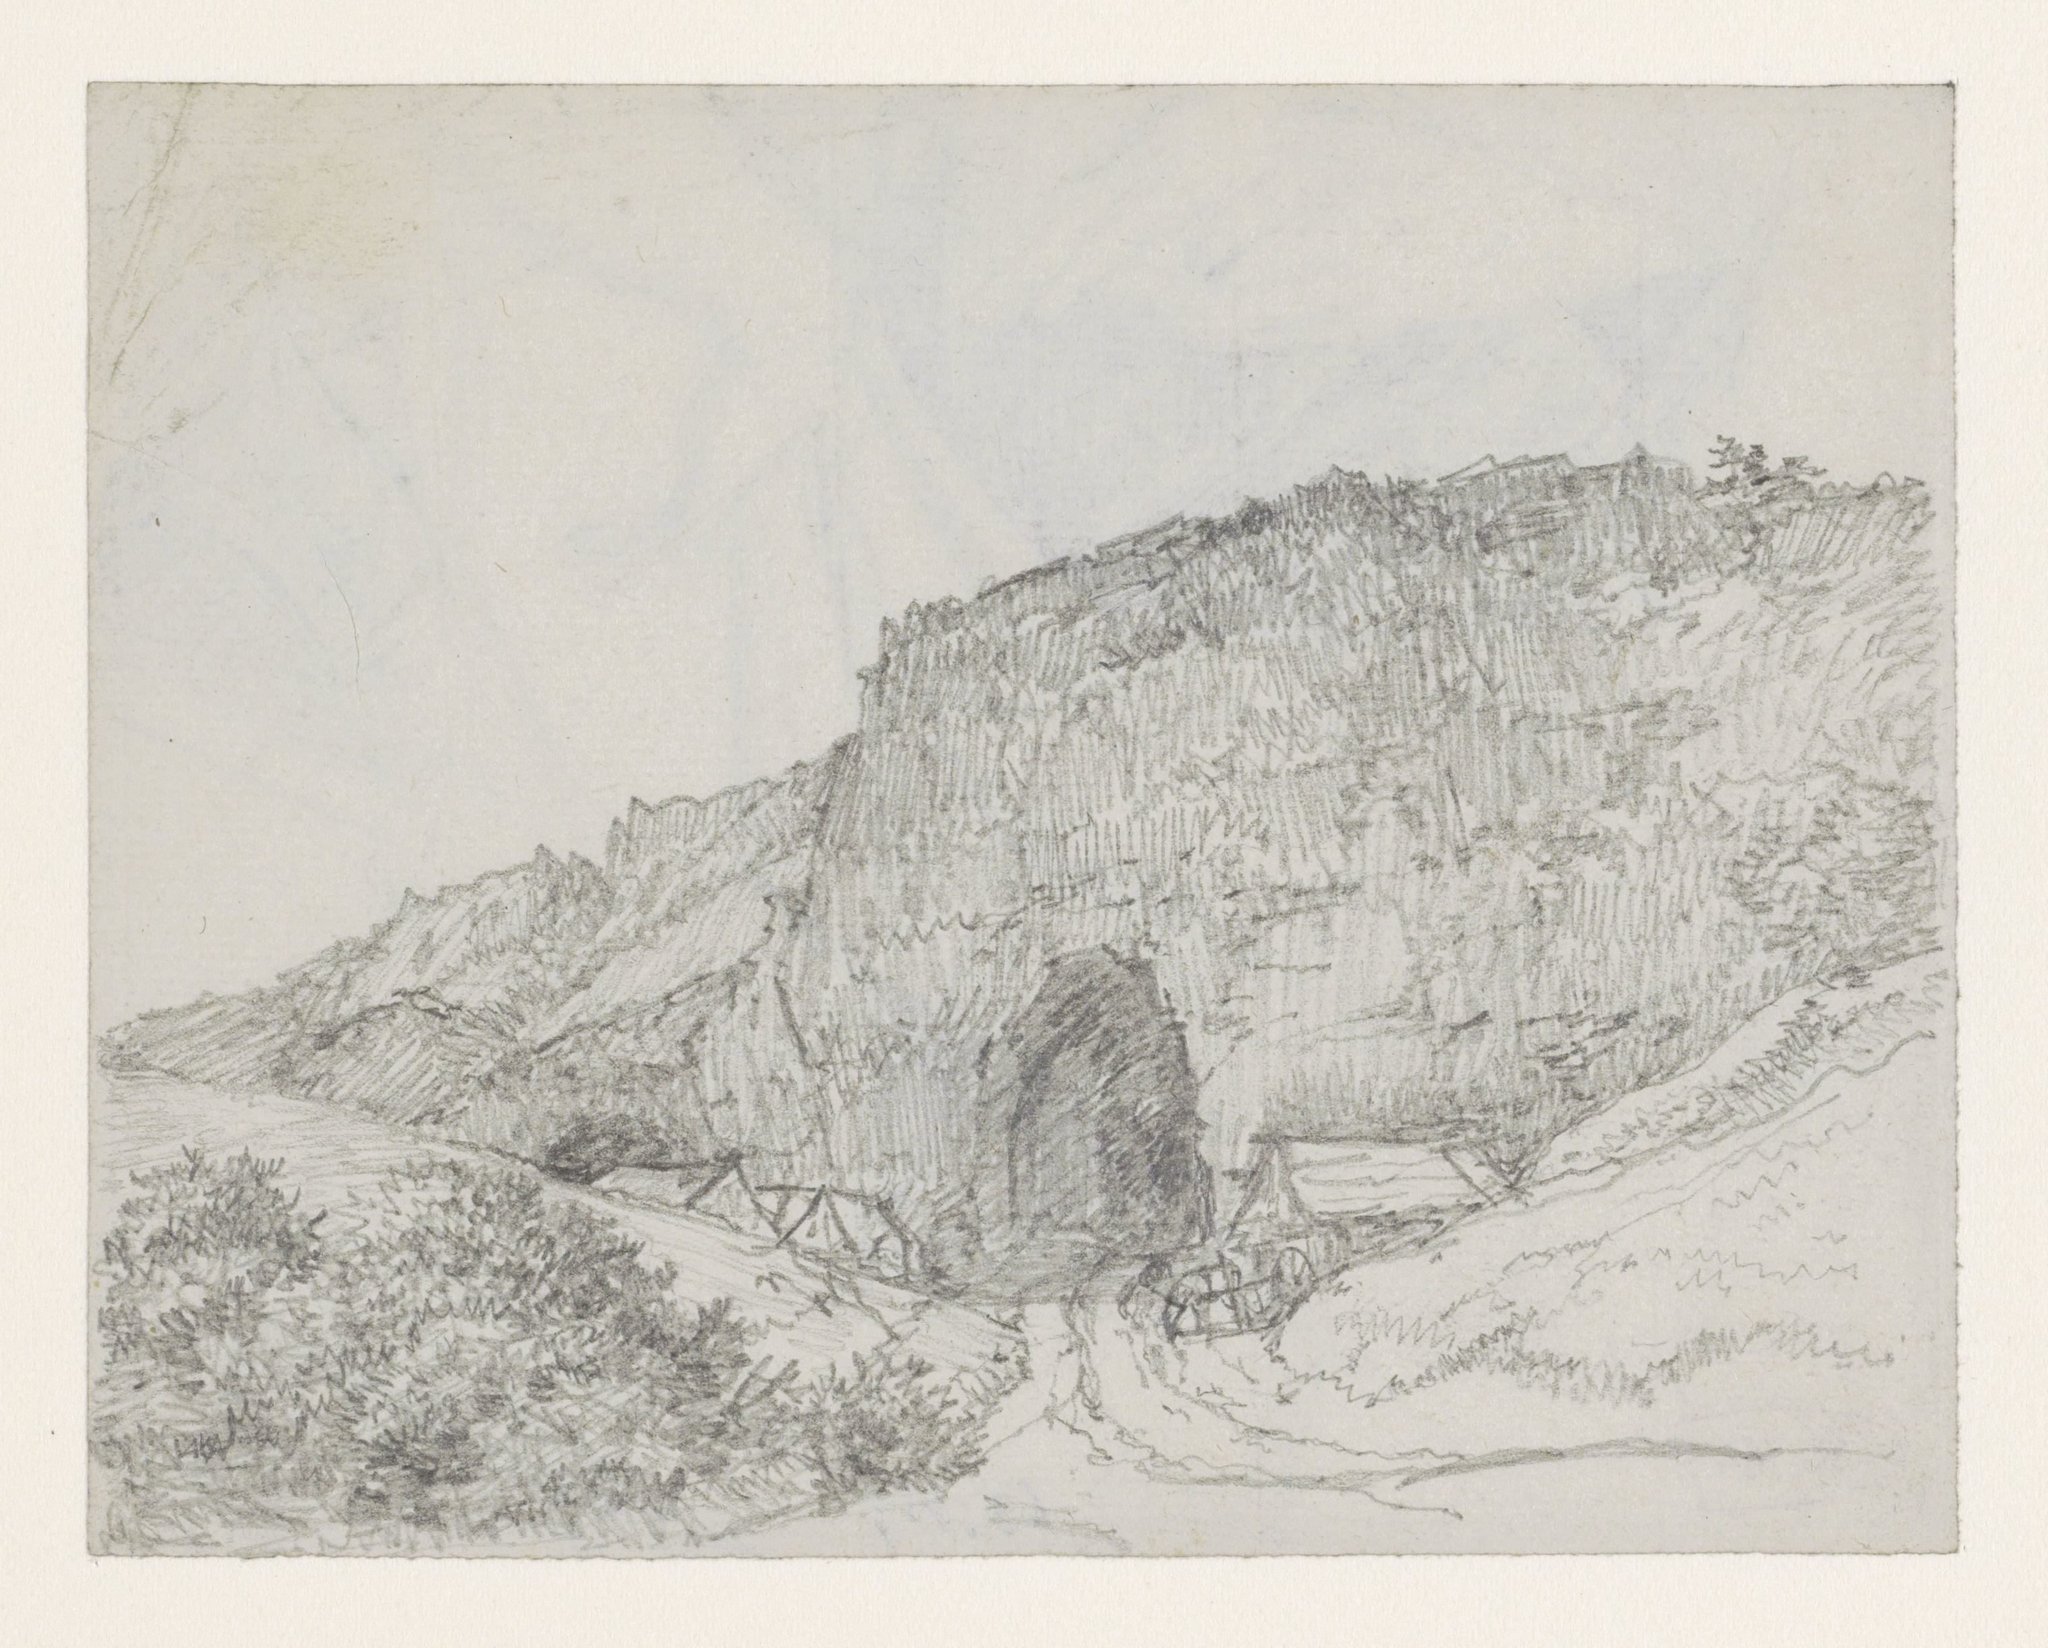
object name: drawing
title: Steengroeve bij Montmartre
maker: georges michel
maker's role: draughtsman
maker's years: 1763-1843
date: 1773-1843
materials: paper, pencil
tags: quarry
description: Een van 120 tekeningen, afkomstig uit een 19e eeuws album met tekeningen van Georges Michel.